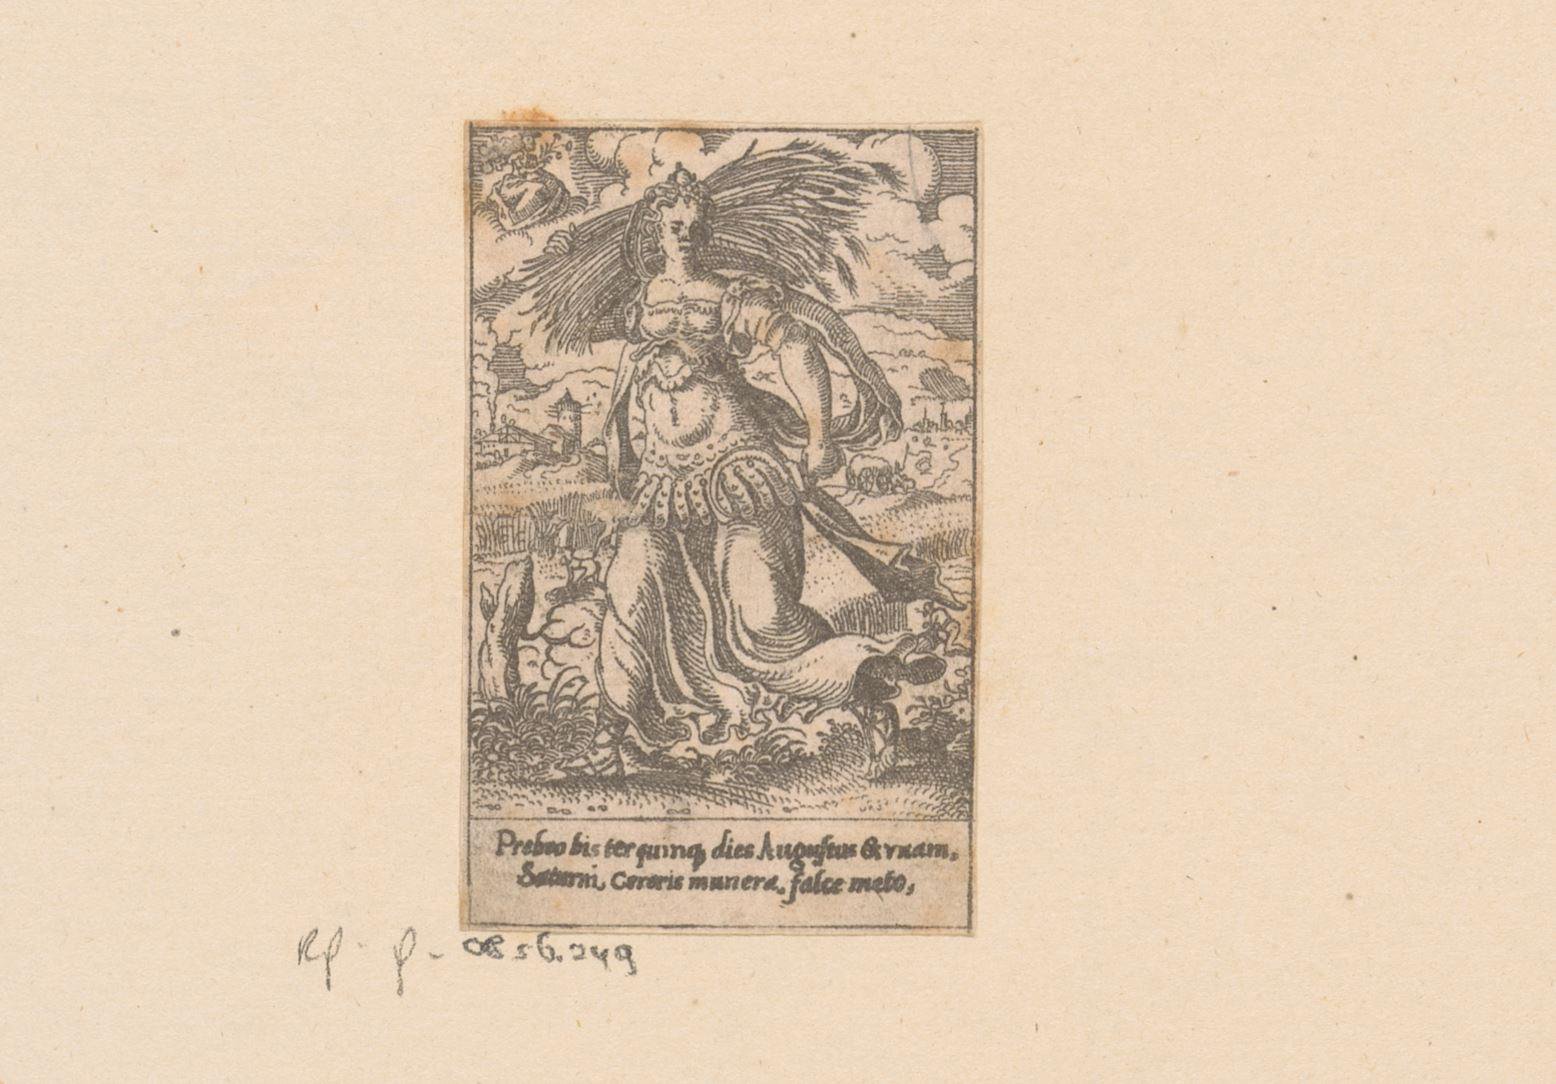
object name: print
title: Maanden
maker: Anonymous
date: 1549-1591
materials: paper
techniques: etching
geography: germany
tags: august; 'agosto' (ripa)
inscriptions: collector's mark: Lugt 2228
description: Niet gespiegelde versie van een serie van twaalf prenten van Jost Amman.